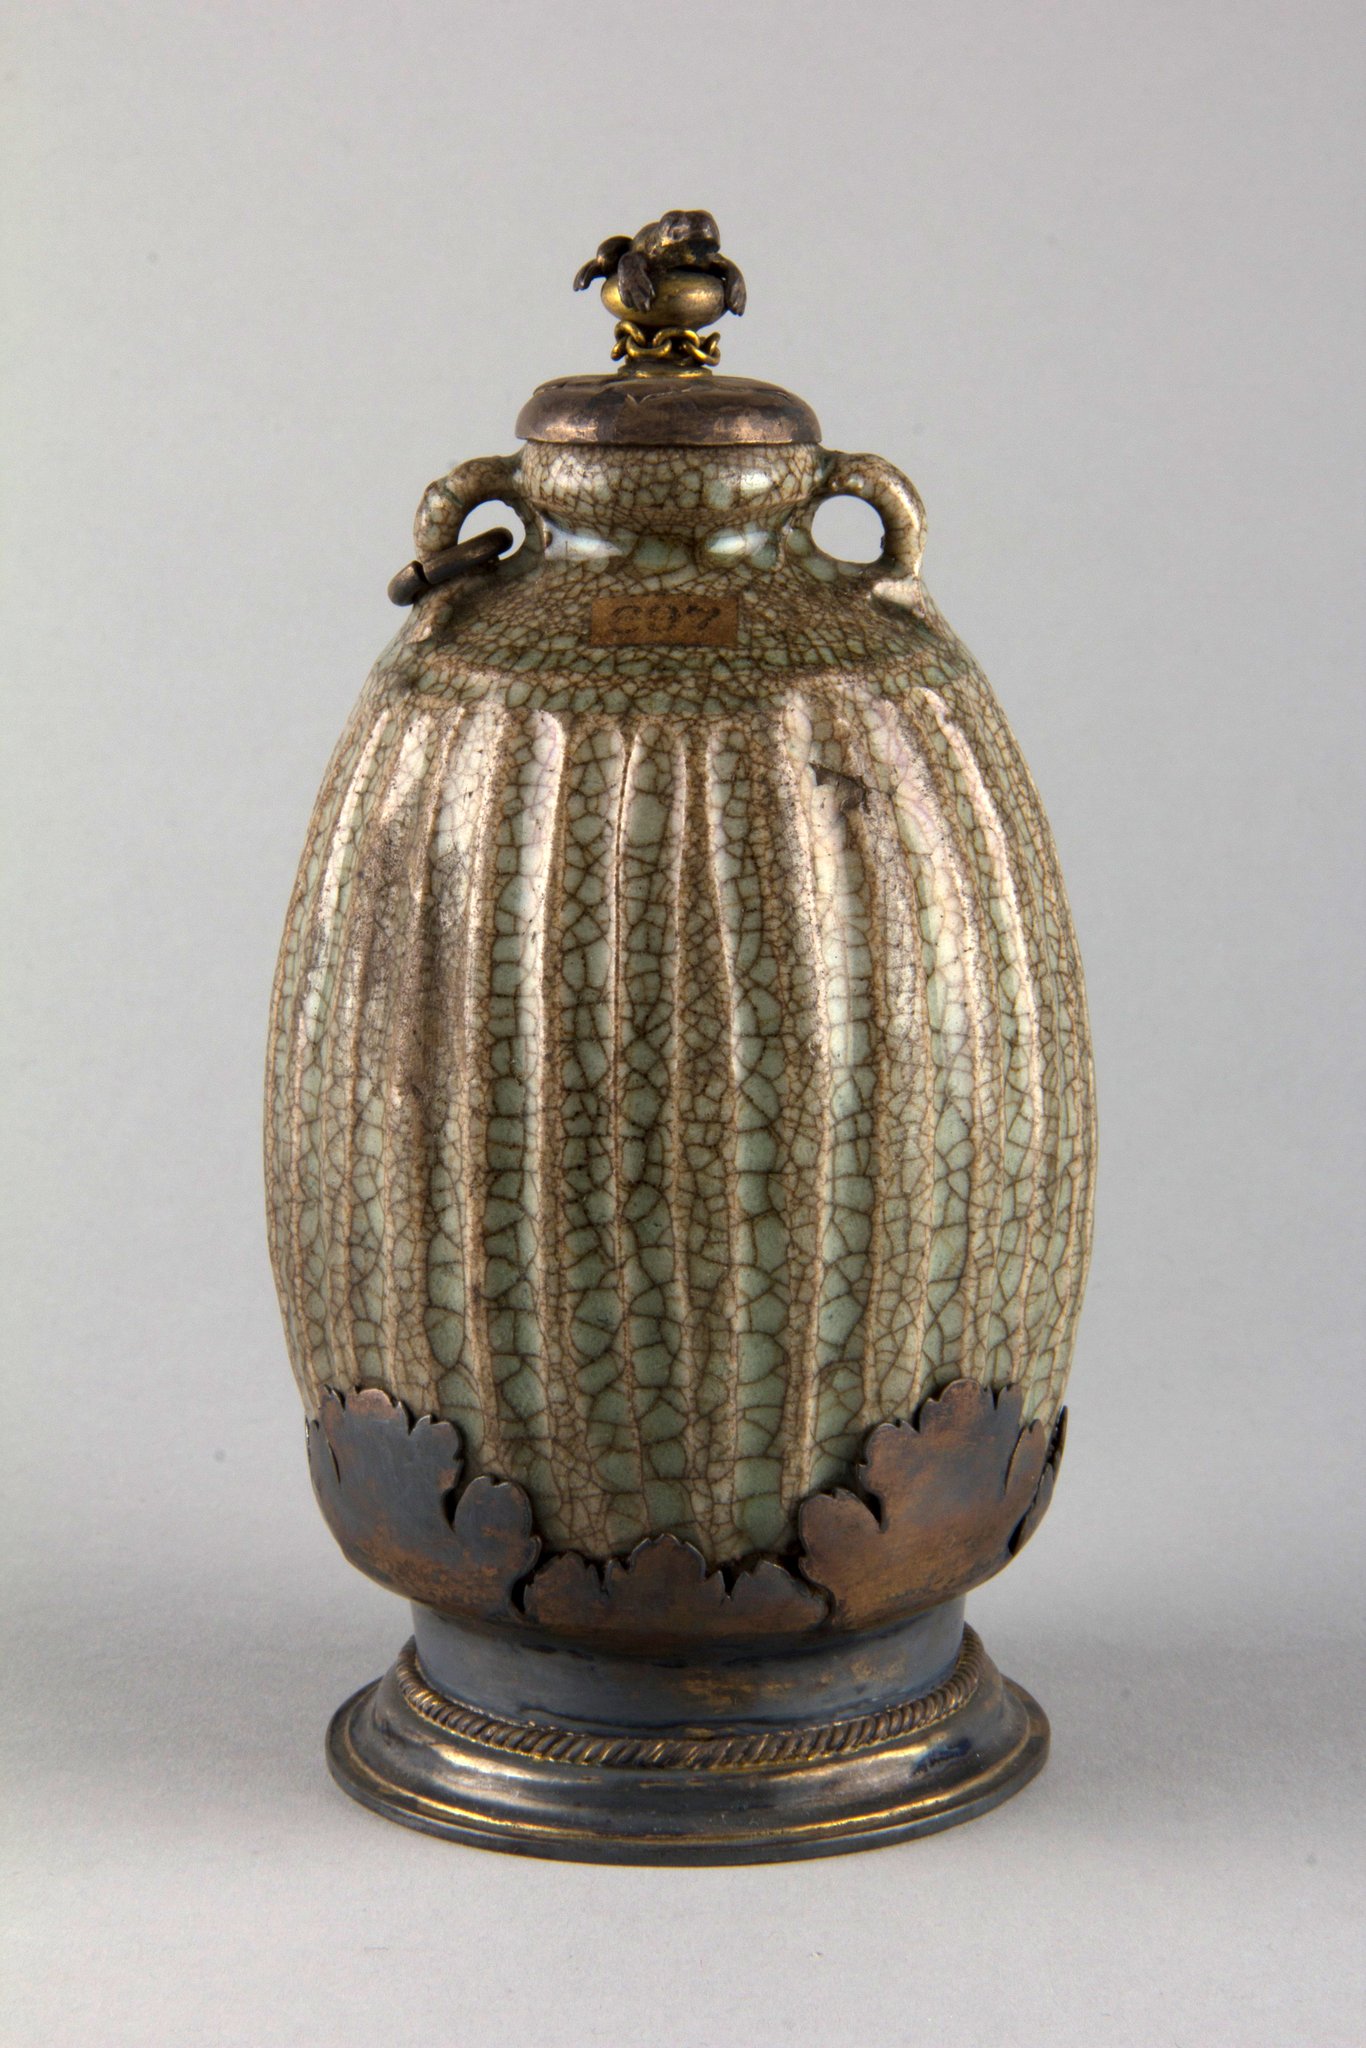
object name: bottle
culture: chinese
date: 1501-1700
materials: glaze, metal, stoneware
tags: birds